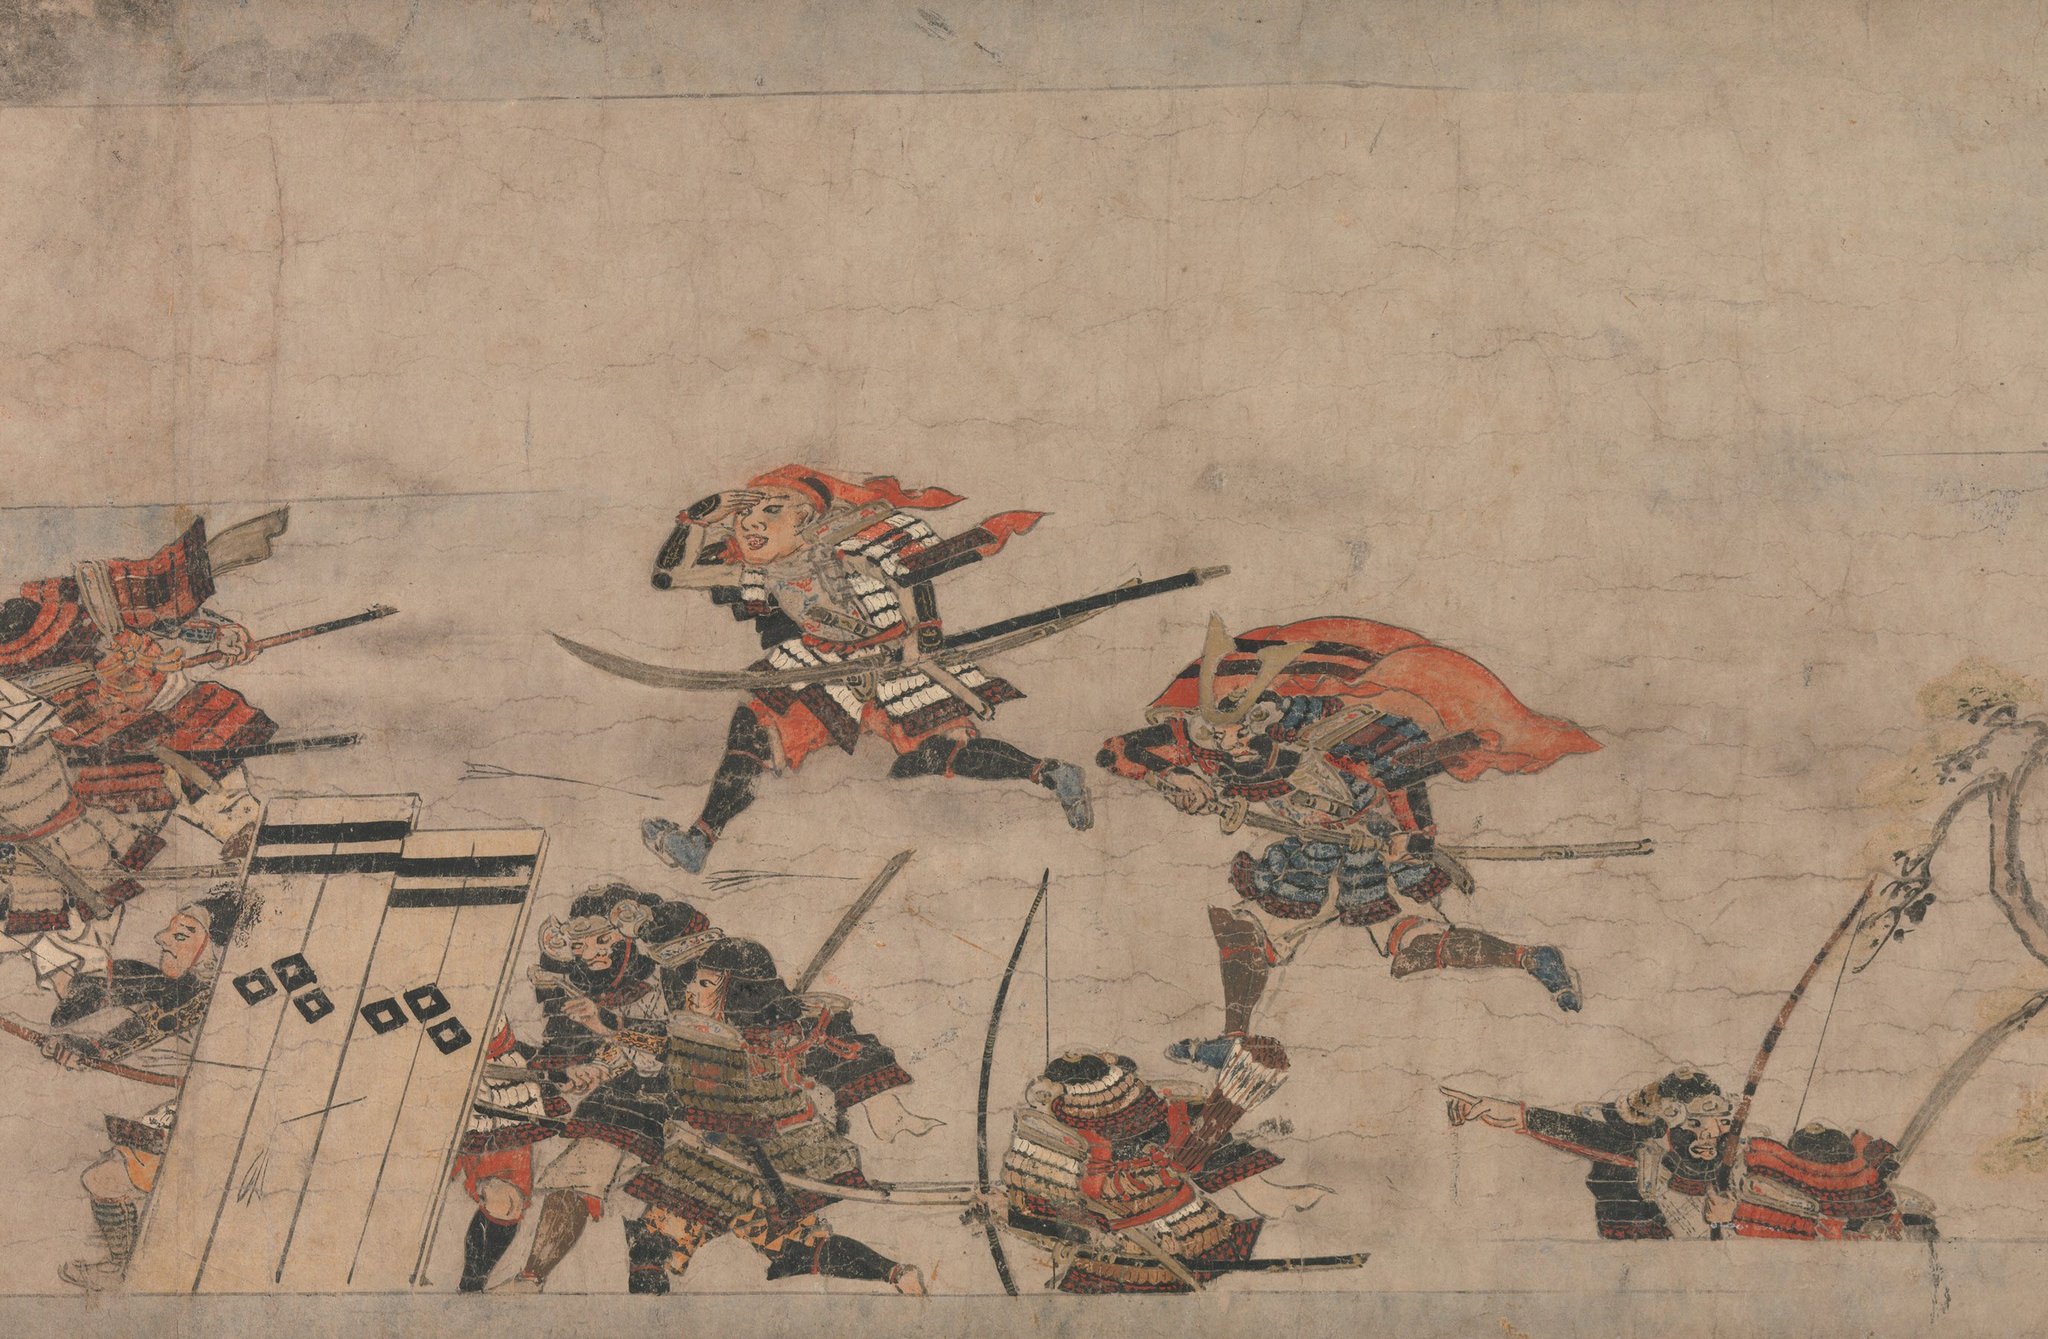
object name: handscroll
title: A Long Tale for an Autumn Night (Aki no yo nagamonogatari)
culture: japanese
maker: unidentified artist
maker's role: artist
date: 1400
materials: gold, ink, paper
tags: bow and arrow,swords,men,landscapes